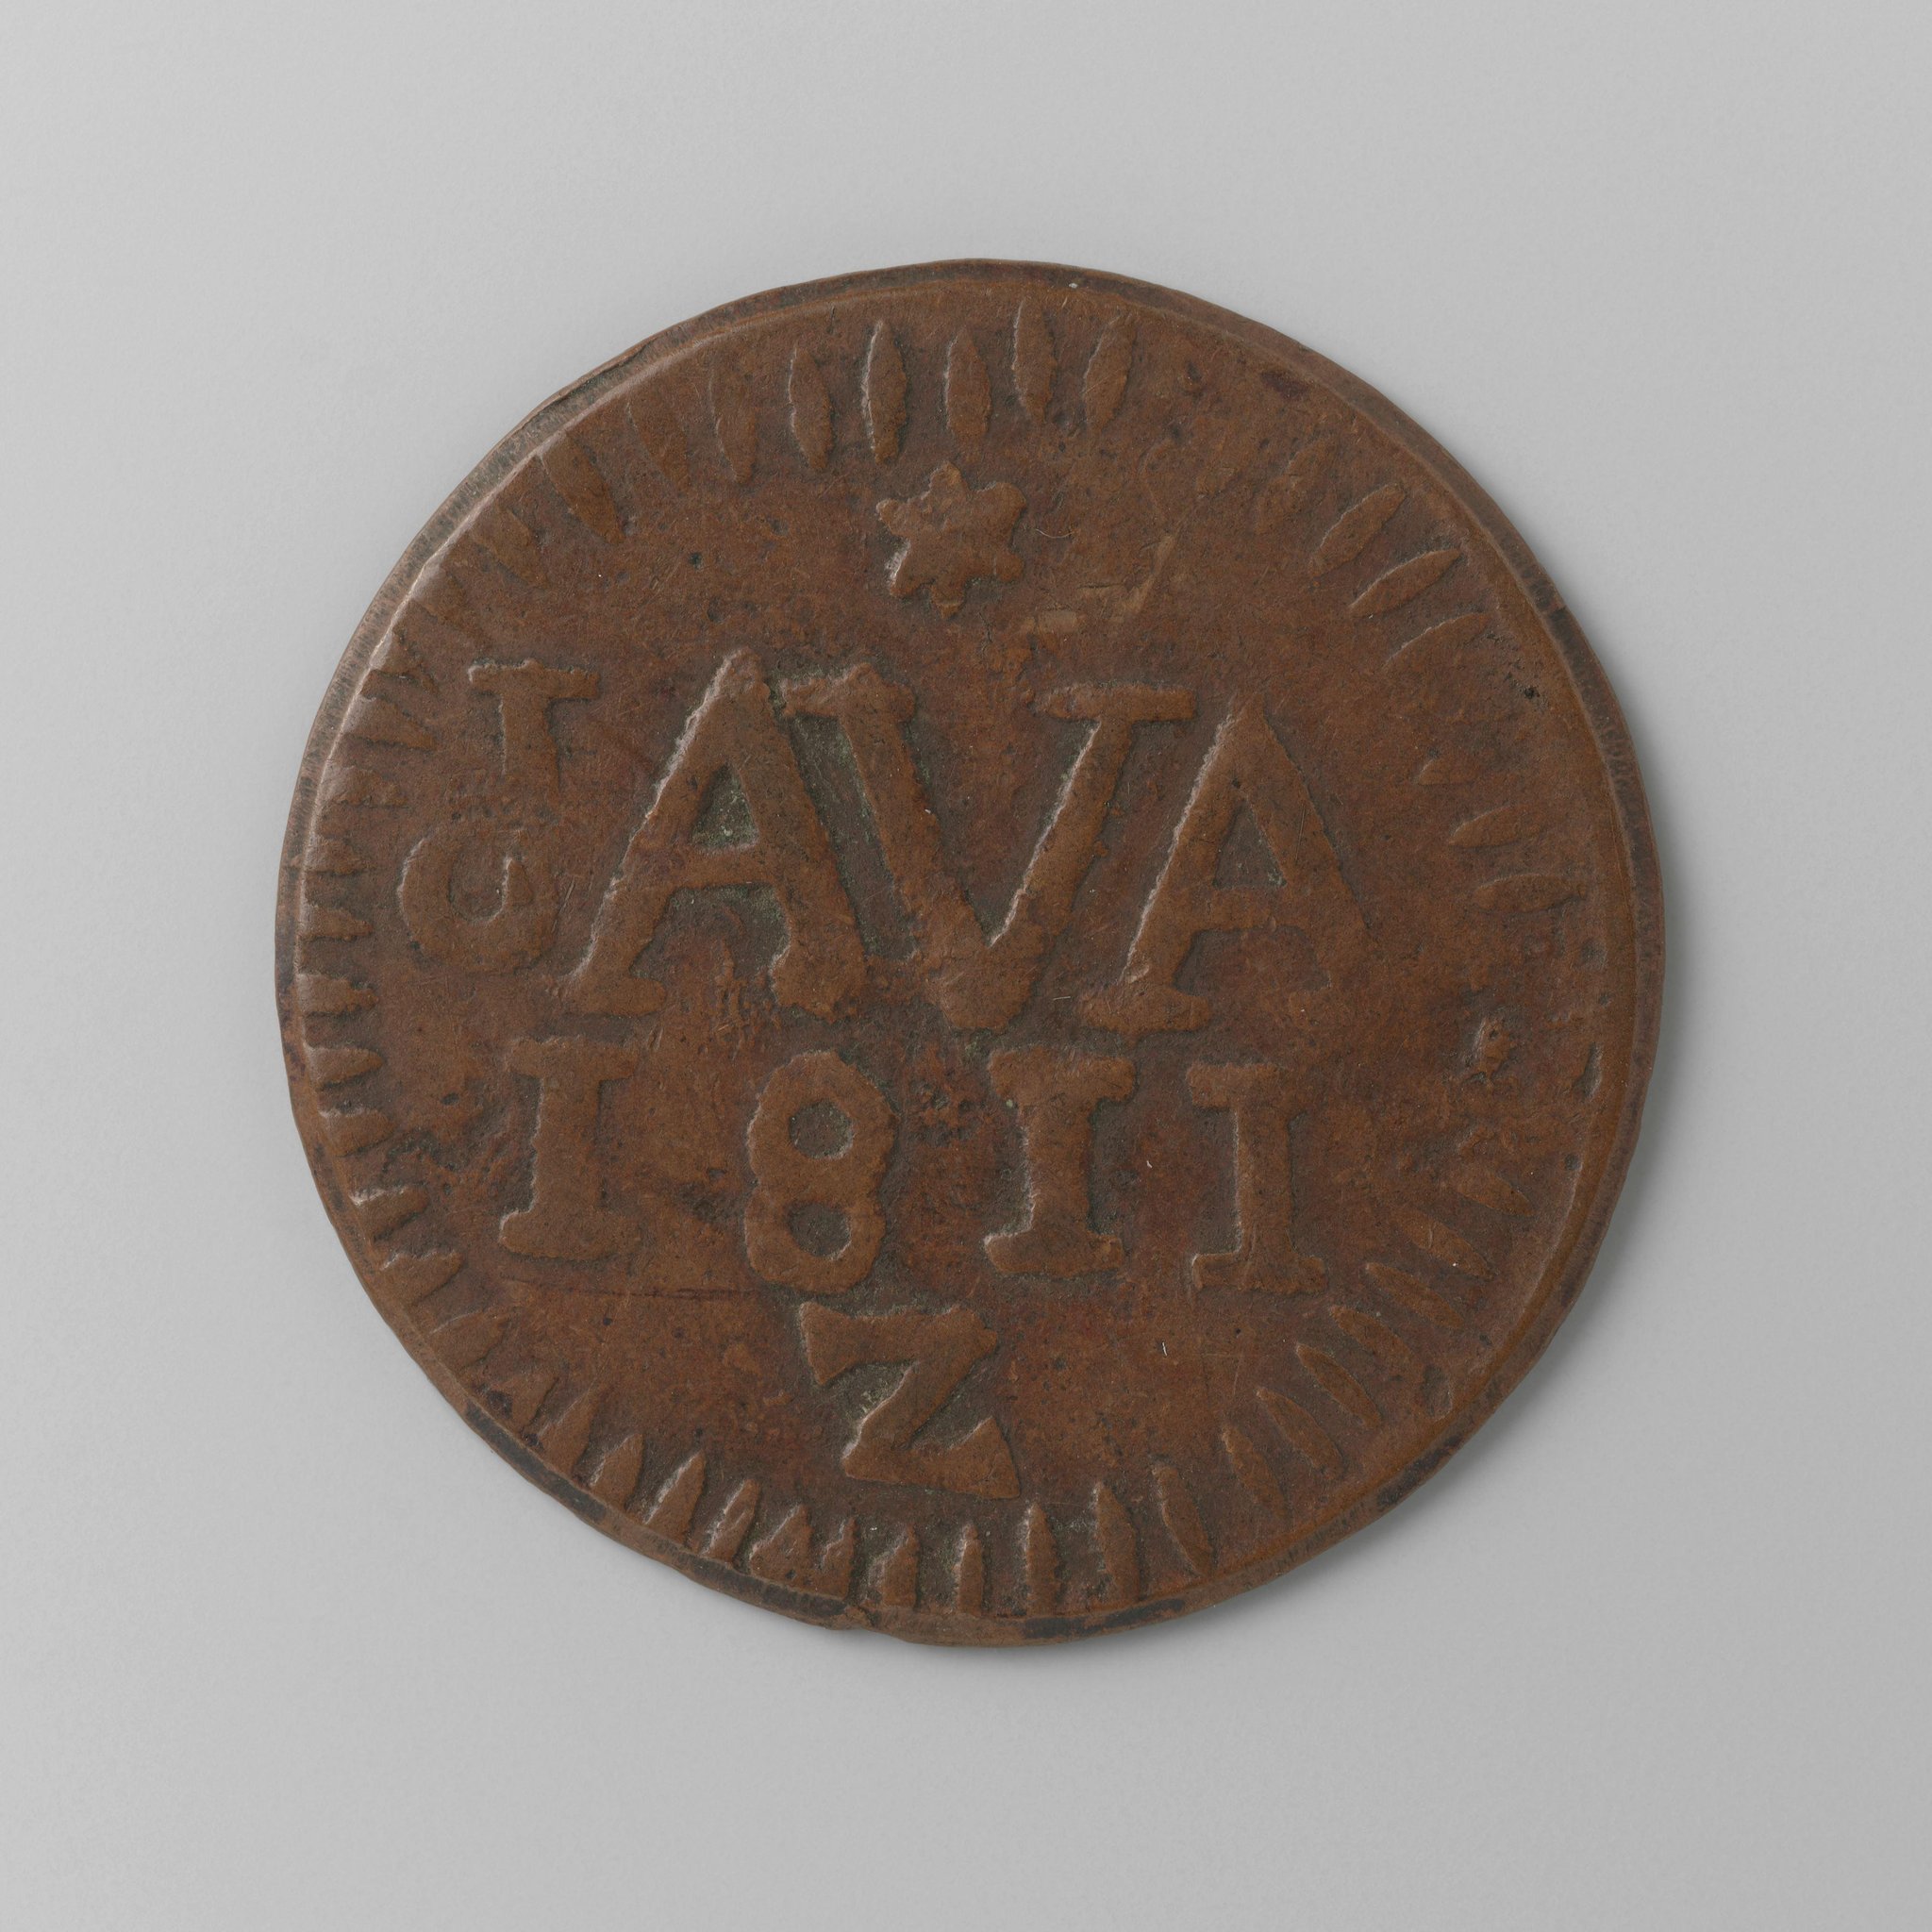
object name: coin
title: Nederlands Indië, ½ stuiver Java, 1811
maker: napoleon i (emperor of the french)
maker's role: generaal, keizer, staatsman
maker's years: 1769-1821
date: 1811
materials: copper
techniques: striking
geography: surabaya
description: Koperen munt. Voorzijde: tussen waarde/aanduiding ½ St ineen gestrengelde initialen L en N van Lodewijk Napoleon. Daarboven muntteken. Keerzijde: eenregelig opschrift, waaronder jaartal. Boven opschrift muntteken en onder jaartal muntmeesterteken Z [=muntmeester Zwekkert].